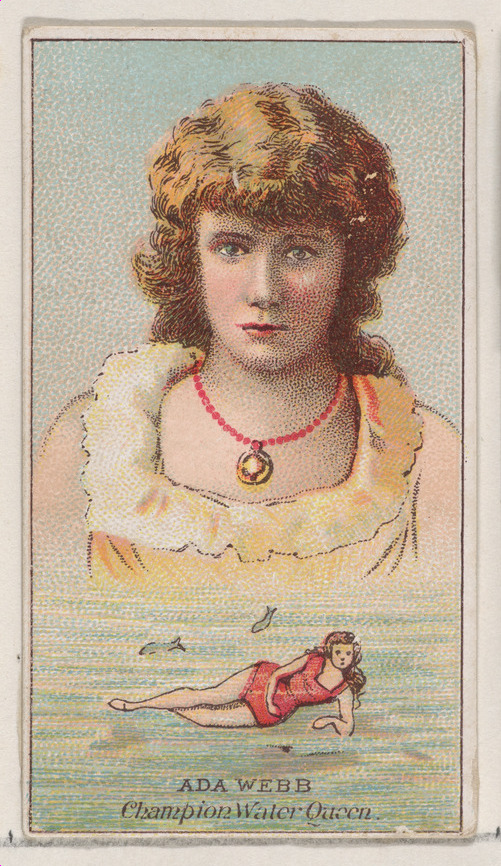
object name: print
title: Ada Webb, Champion Water Queen, from the Champions of Games and Sports series (N184, Type 2) issued by W.S. Kimball & Co.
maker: w.s. kimball & co.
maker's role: publisher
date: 1887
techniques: color lithograph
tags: women